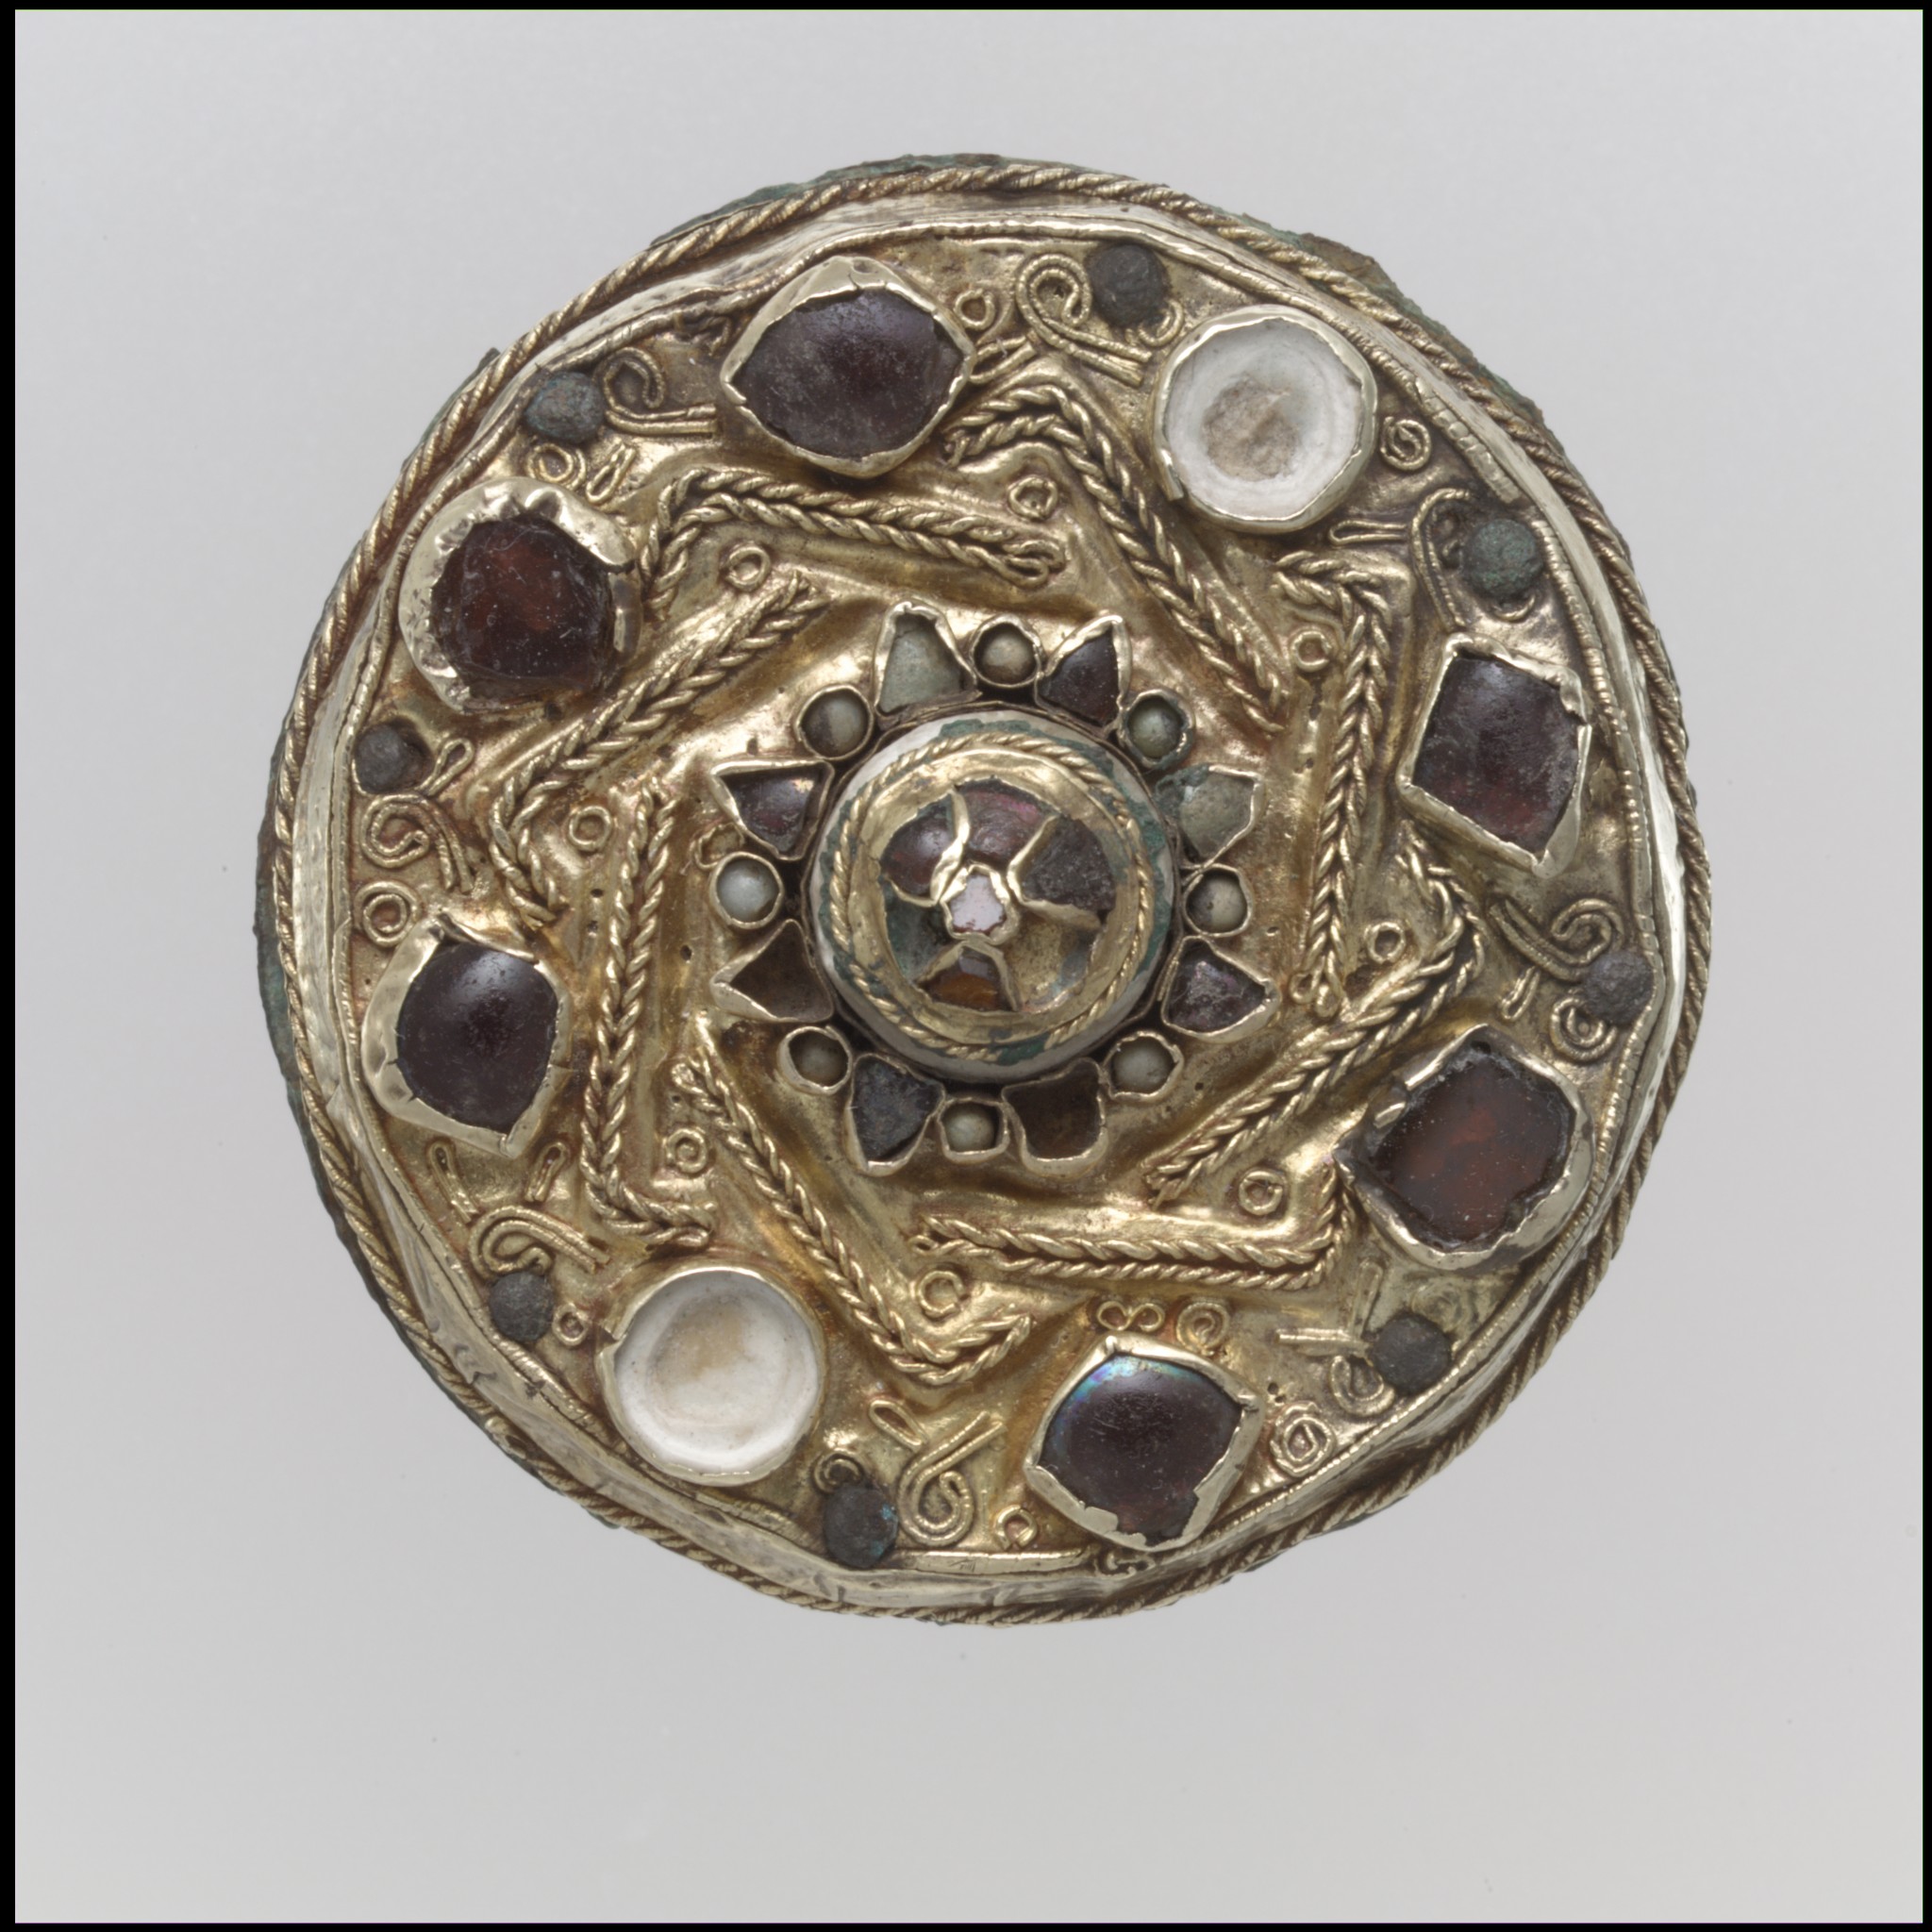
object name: brooch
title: Disk Brooch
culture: frankish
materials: amber, gemstone, glass, gold, mother of pearl